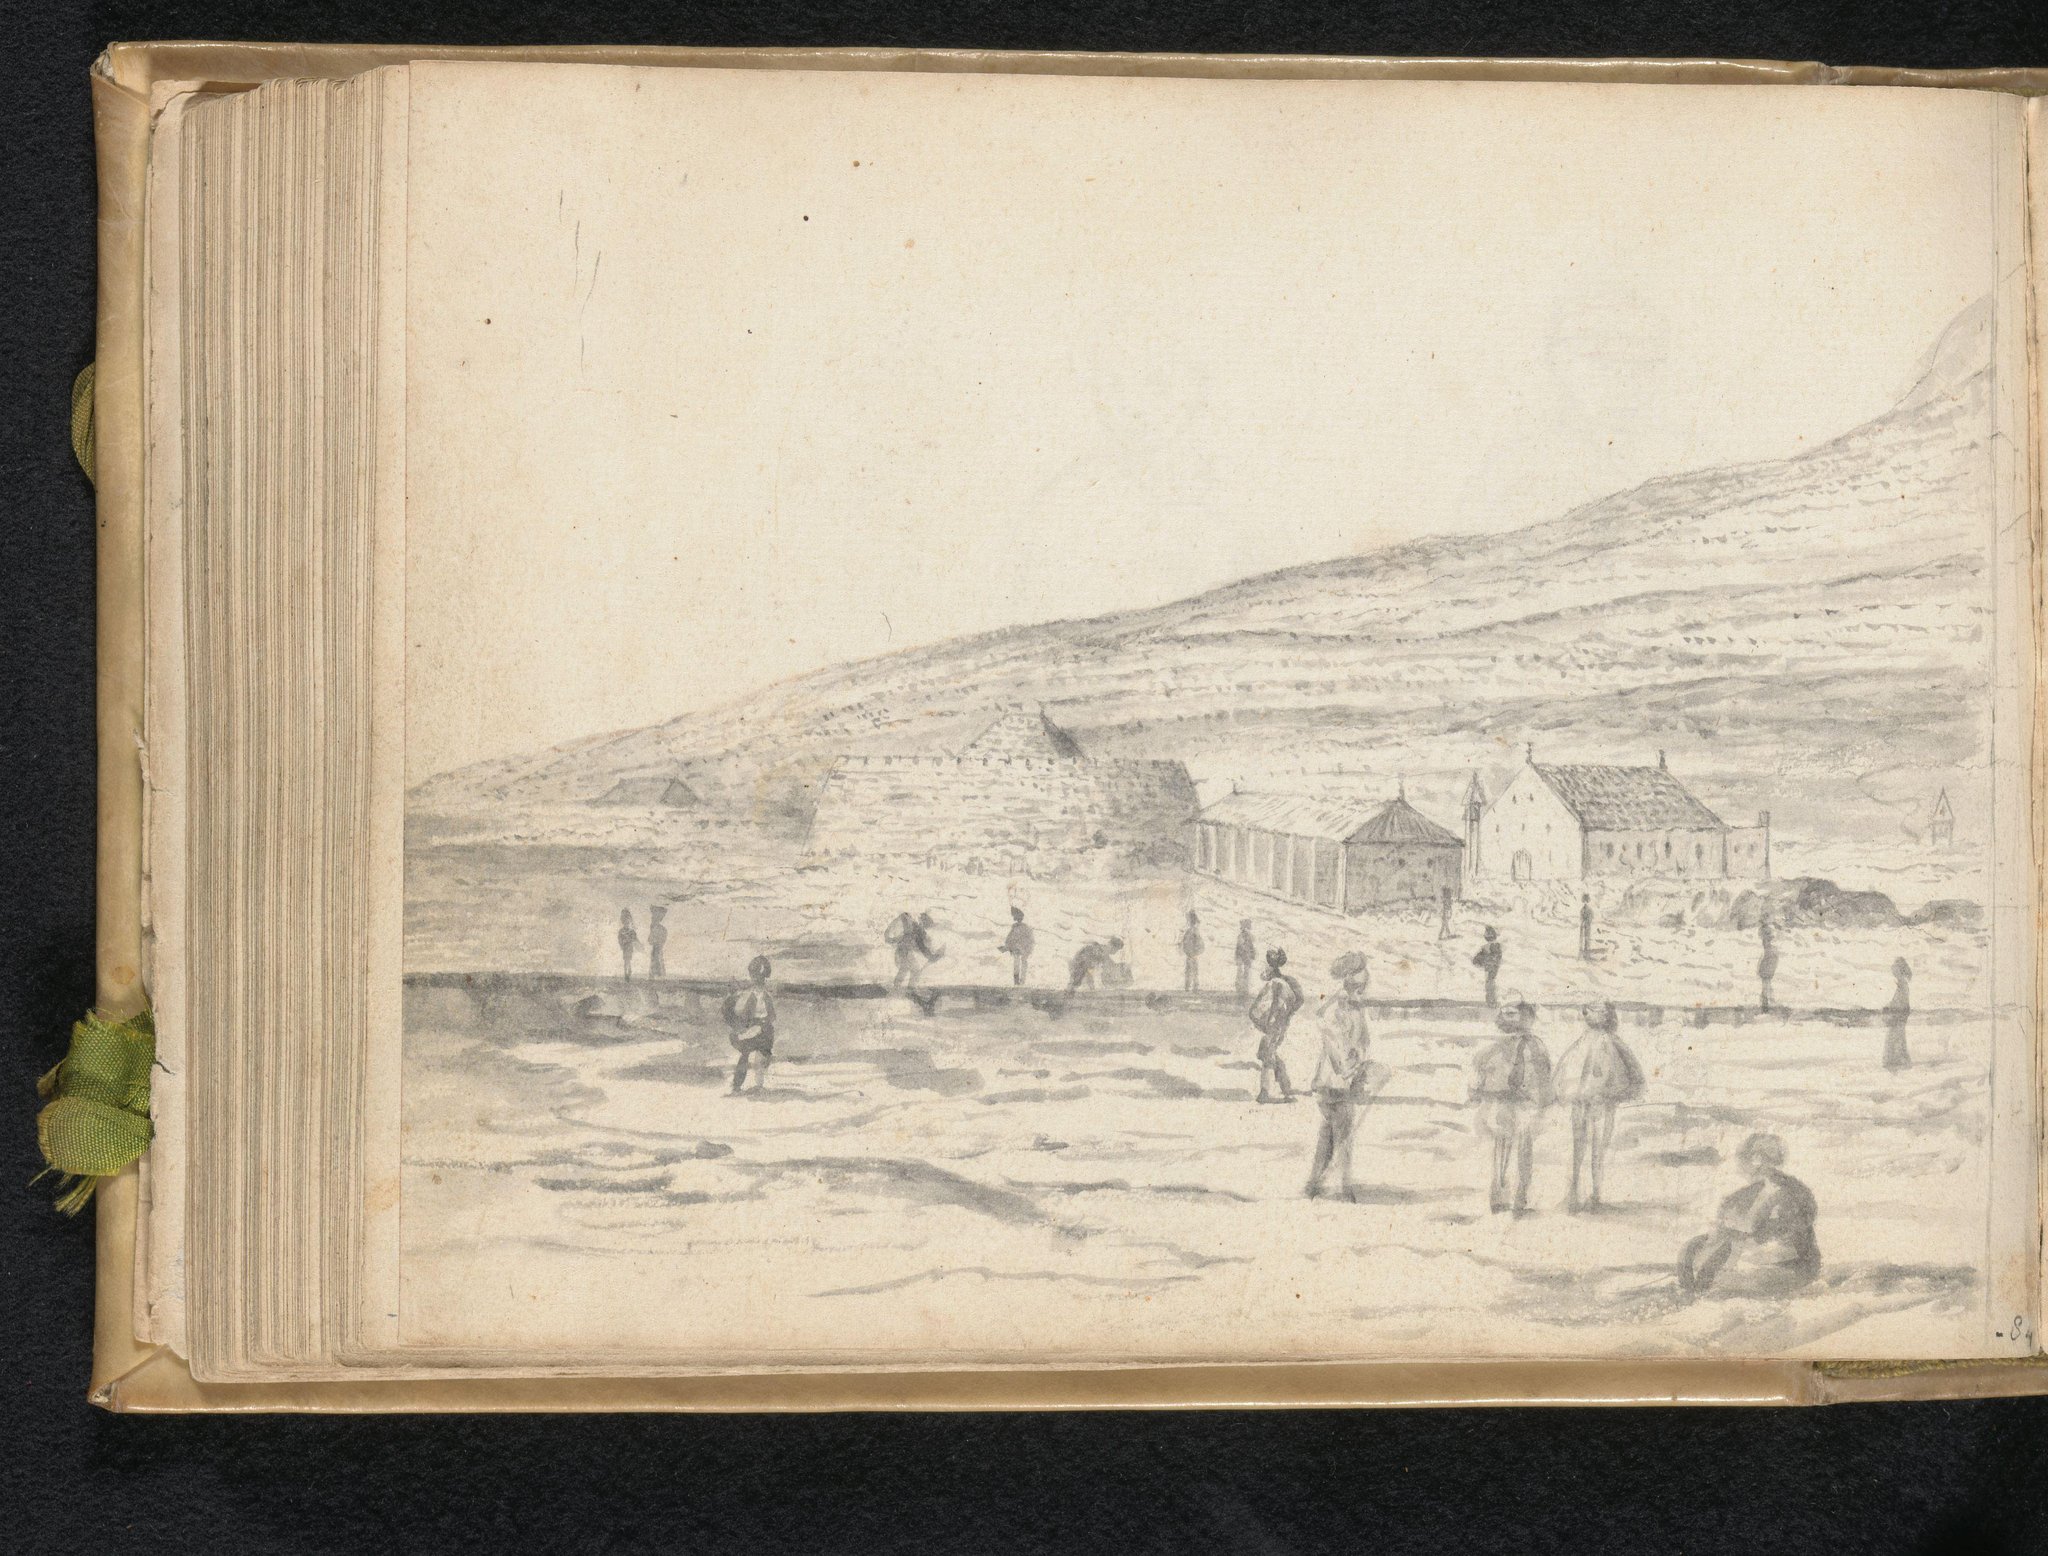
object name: sketchbook leaf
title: View of the Malwana fortress, with a warehouse and church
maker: esaias boursse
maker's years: 1631-1672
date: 1662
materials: ink, paper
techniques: brush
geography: sri lanka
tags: fortress, asiatic races and peoples (srilankans), sri lanka